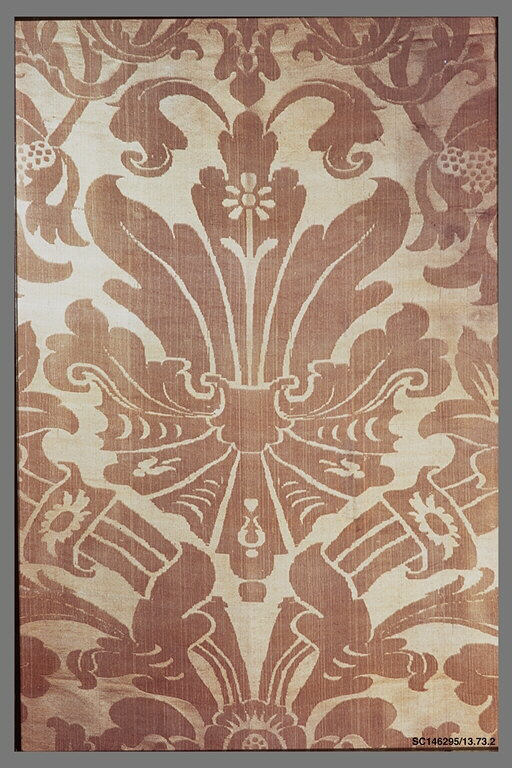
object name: piece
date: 1601-1700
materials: silk